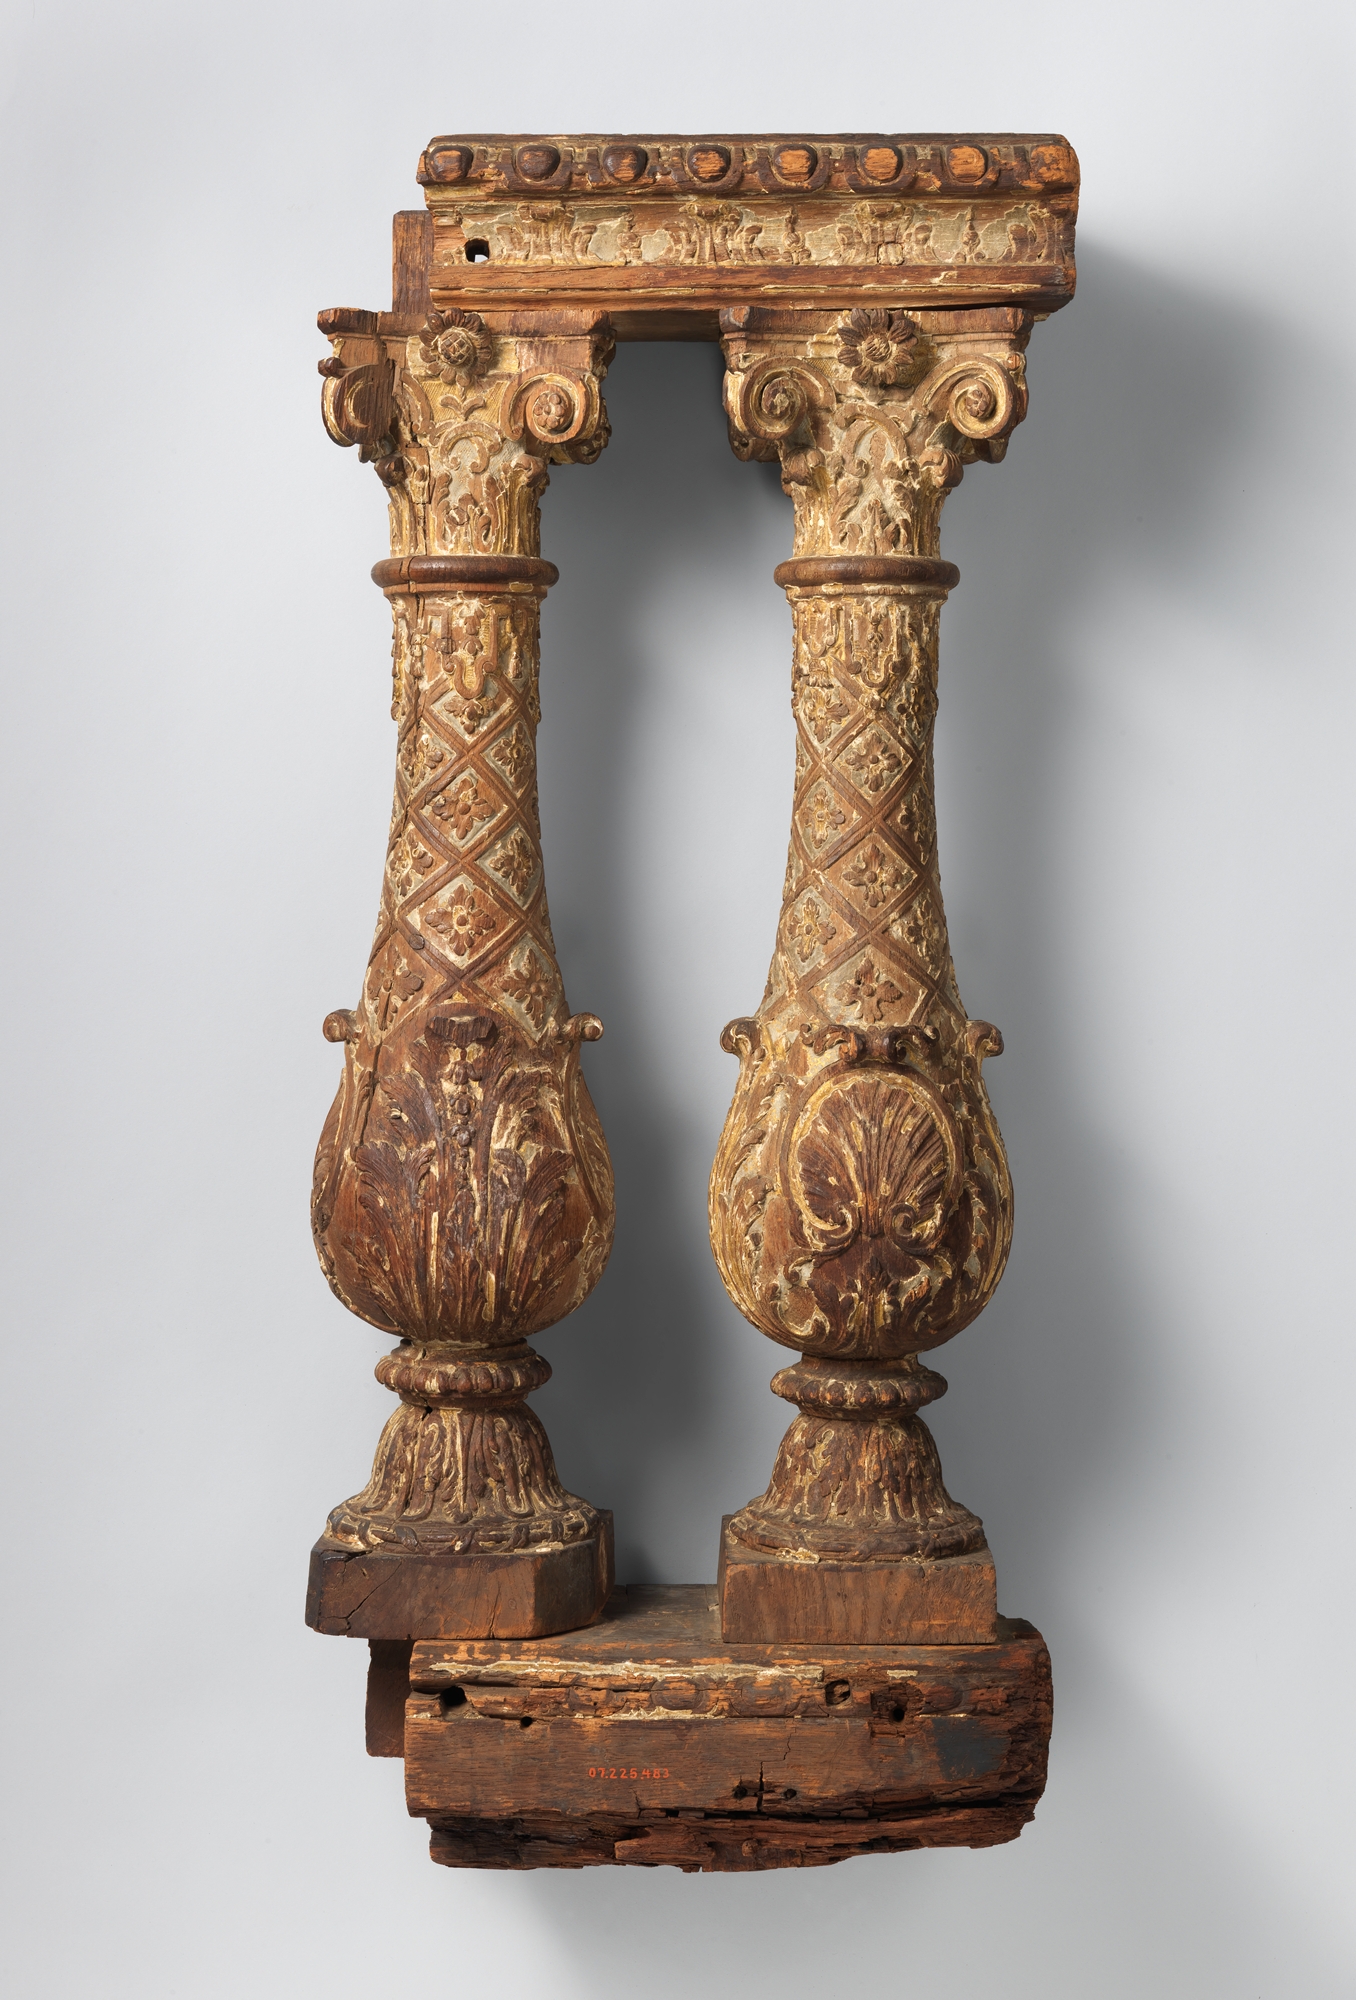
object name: baluster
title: Pair of balusters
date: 1667-1700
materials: wood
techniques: carving, gilding, painting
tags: acanthus